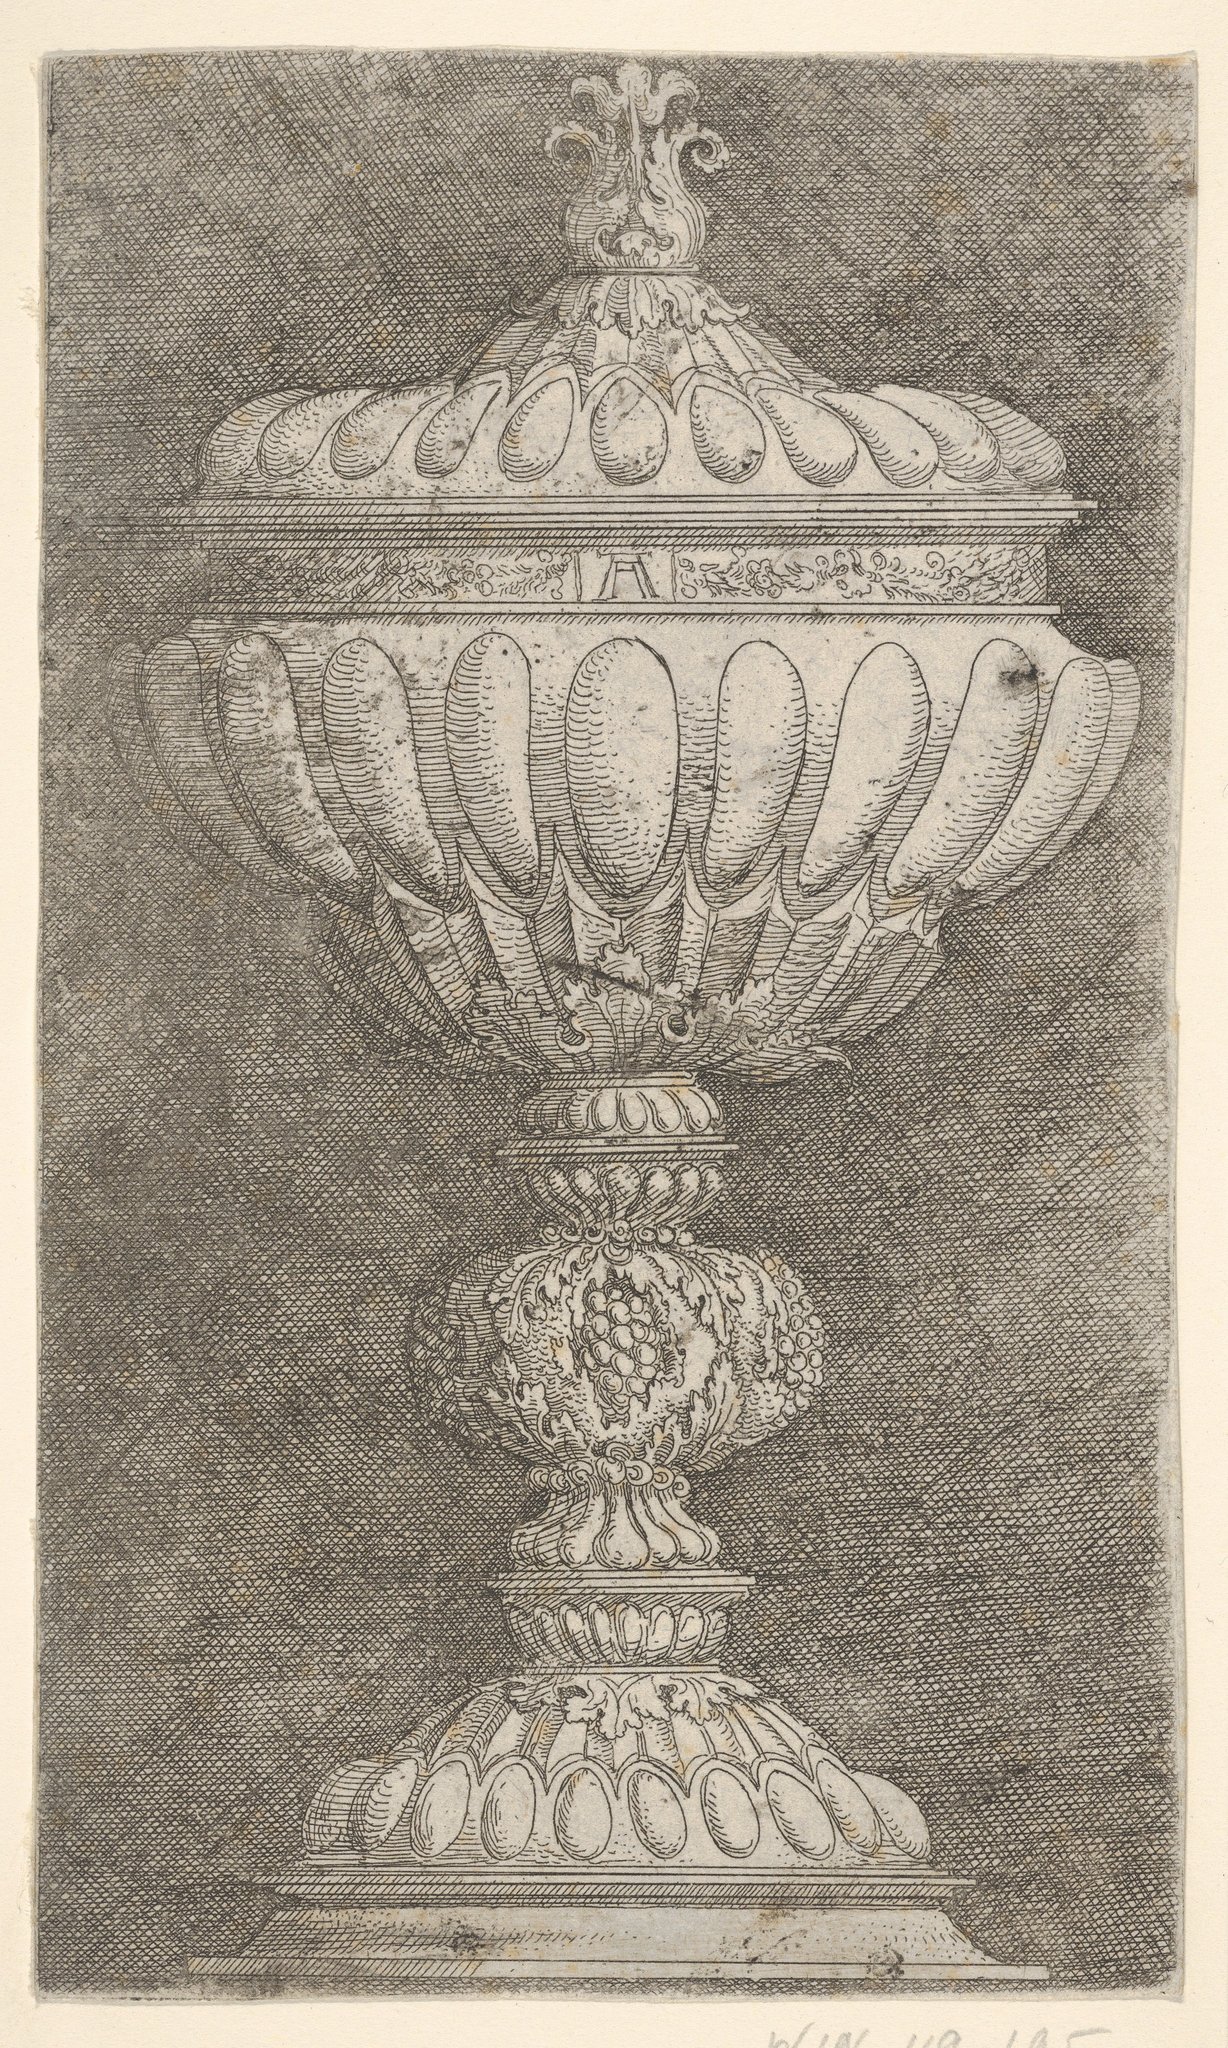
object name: print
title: Covered Goblet with Grapes on the Stem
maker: albrecht altdorfer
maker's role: artist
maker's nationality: german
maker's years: 1480-1538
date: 1500-1538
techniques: etching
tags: goblets